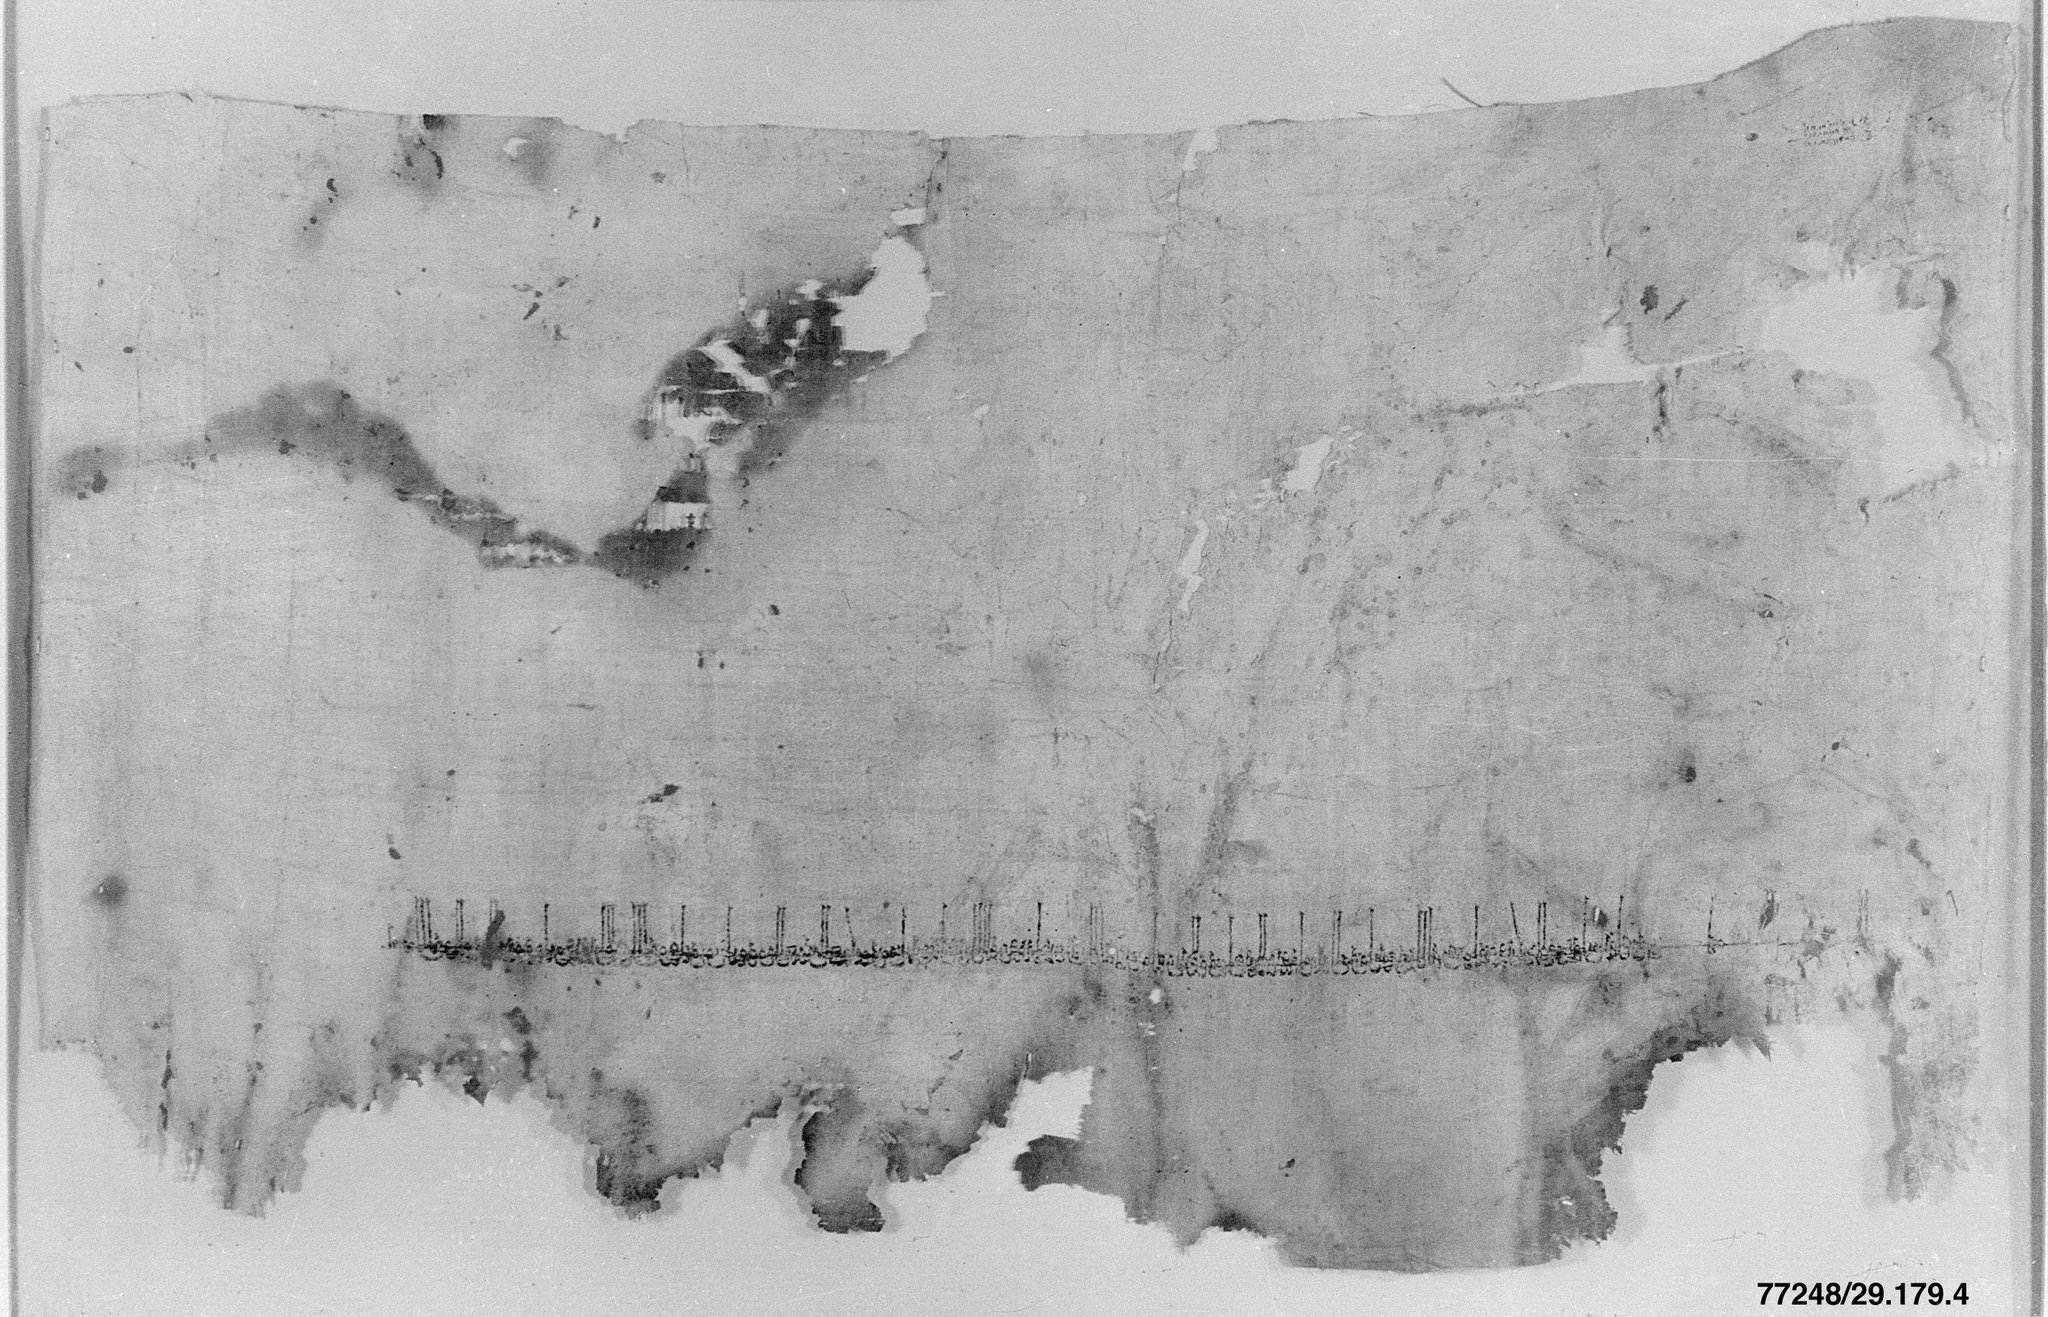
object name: textile fragment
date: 801-1000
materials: linen, silk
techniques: embroidery, weave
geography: egypt